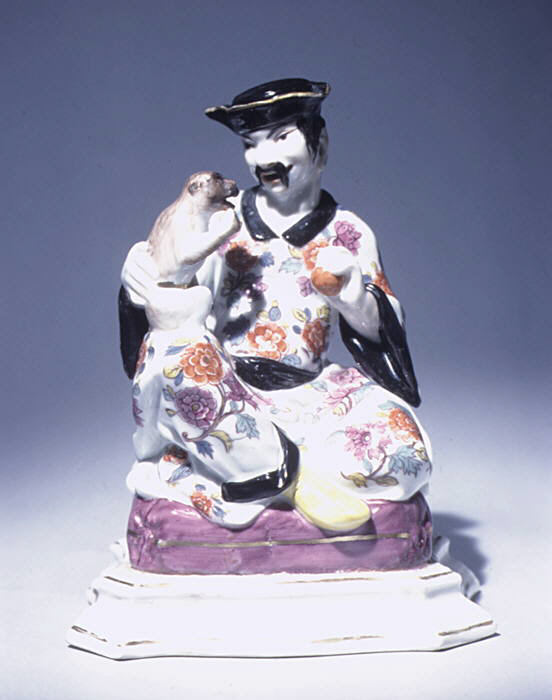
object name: figure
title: Figure in the form of a seated man (one of a pair)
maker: meissen manufactory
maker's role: manufactory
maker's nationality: german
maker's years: 1710-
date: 1735-1740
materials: hard paste porcelain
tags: animals,men